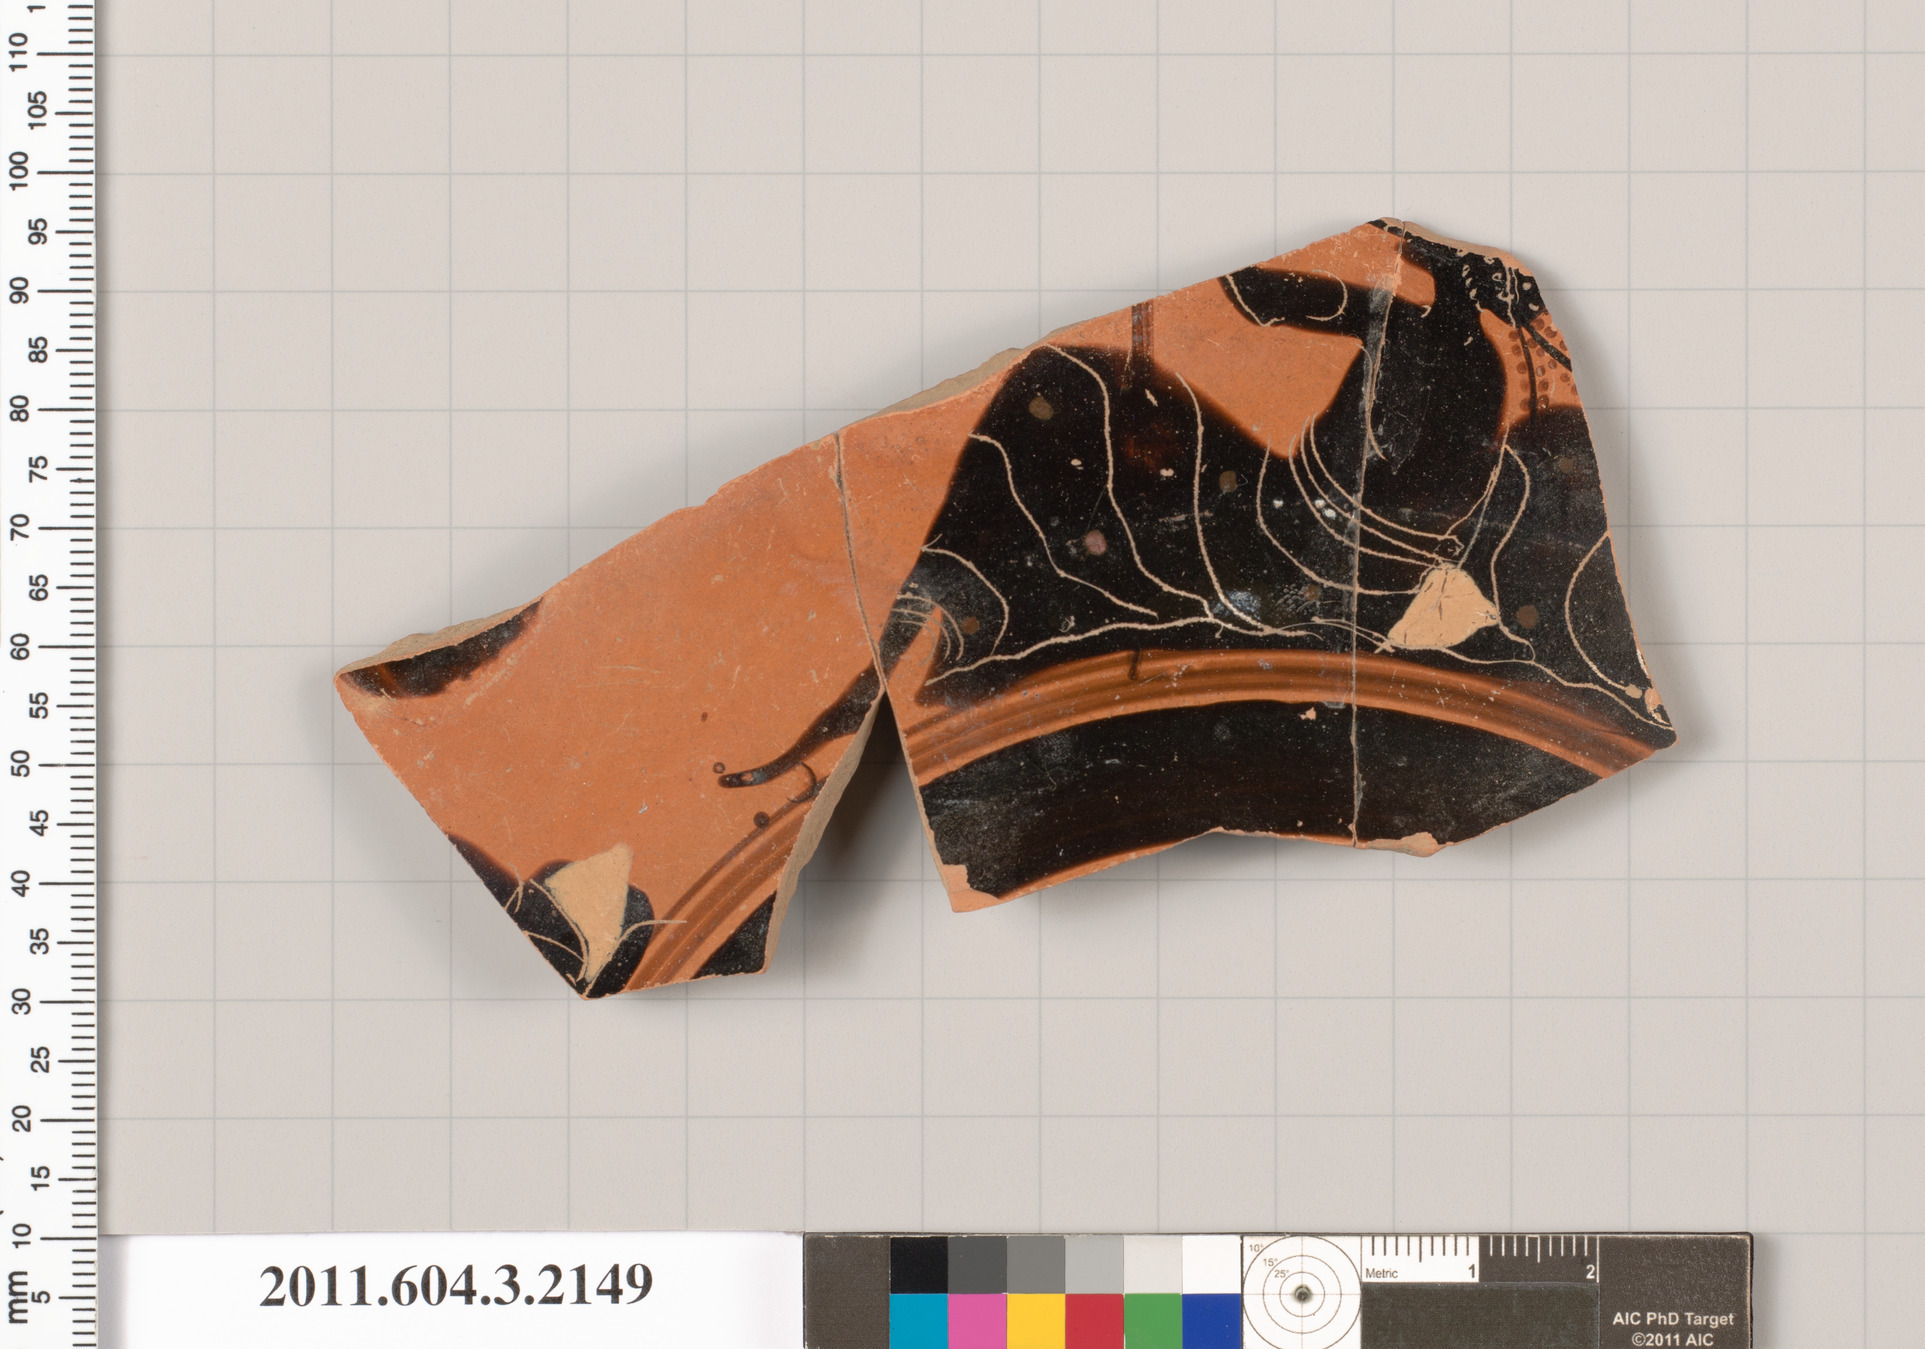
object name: kylix fragment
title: Terracotta fragment of a kylix (drinking cup)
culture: greek, attic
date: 525-501 BCE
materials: terracotta